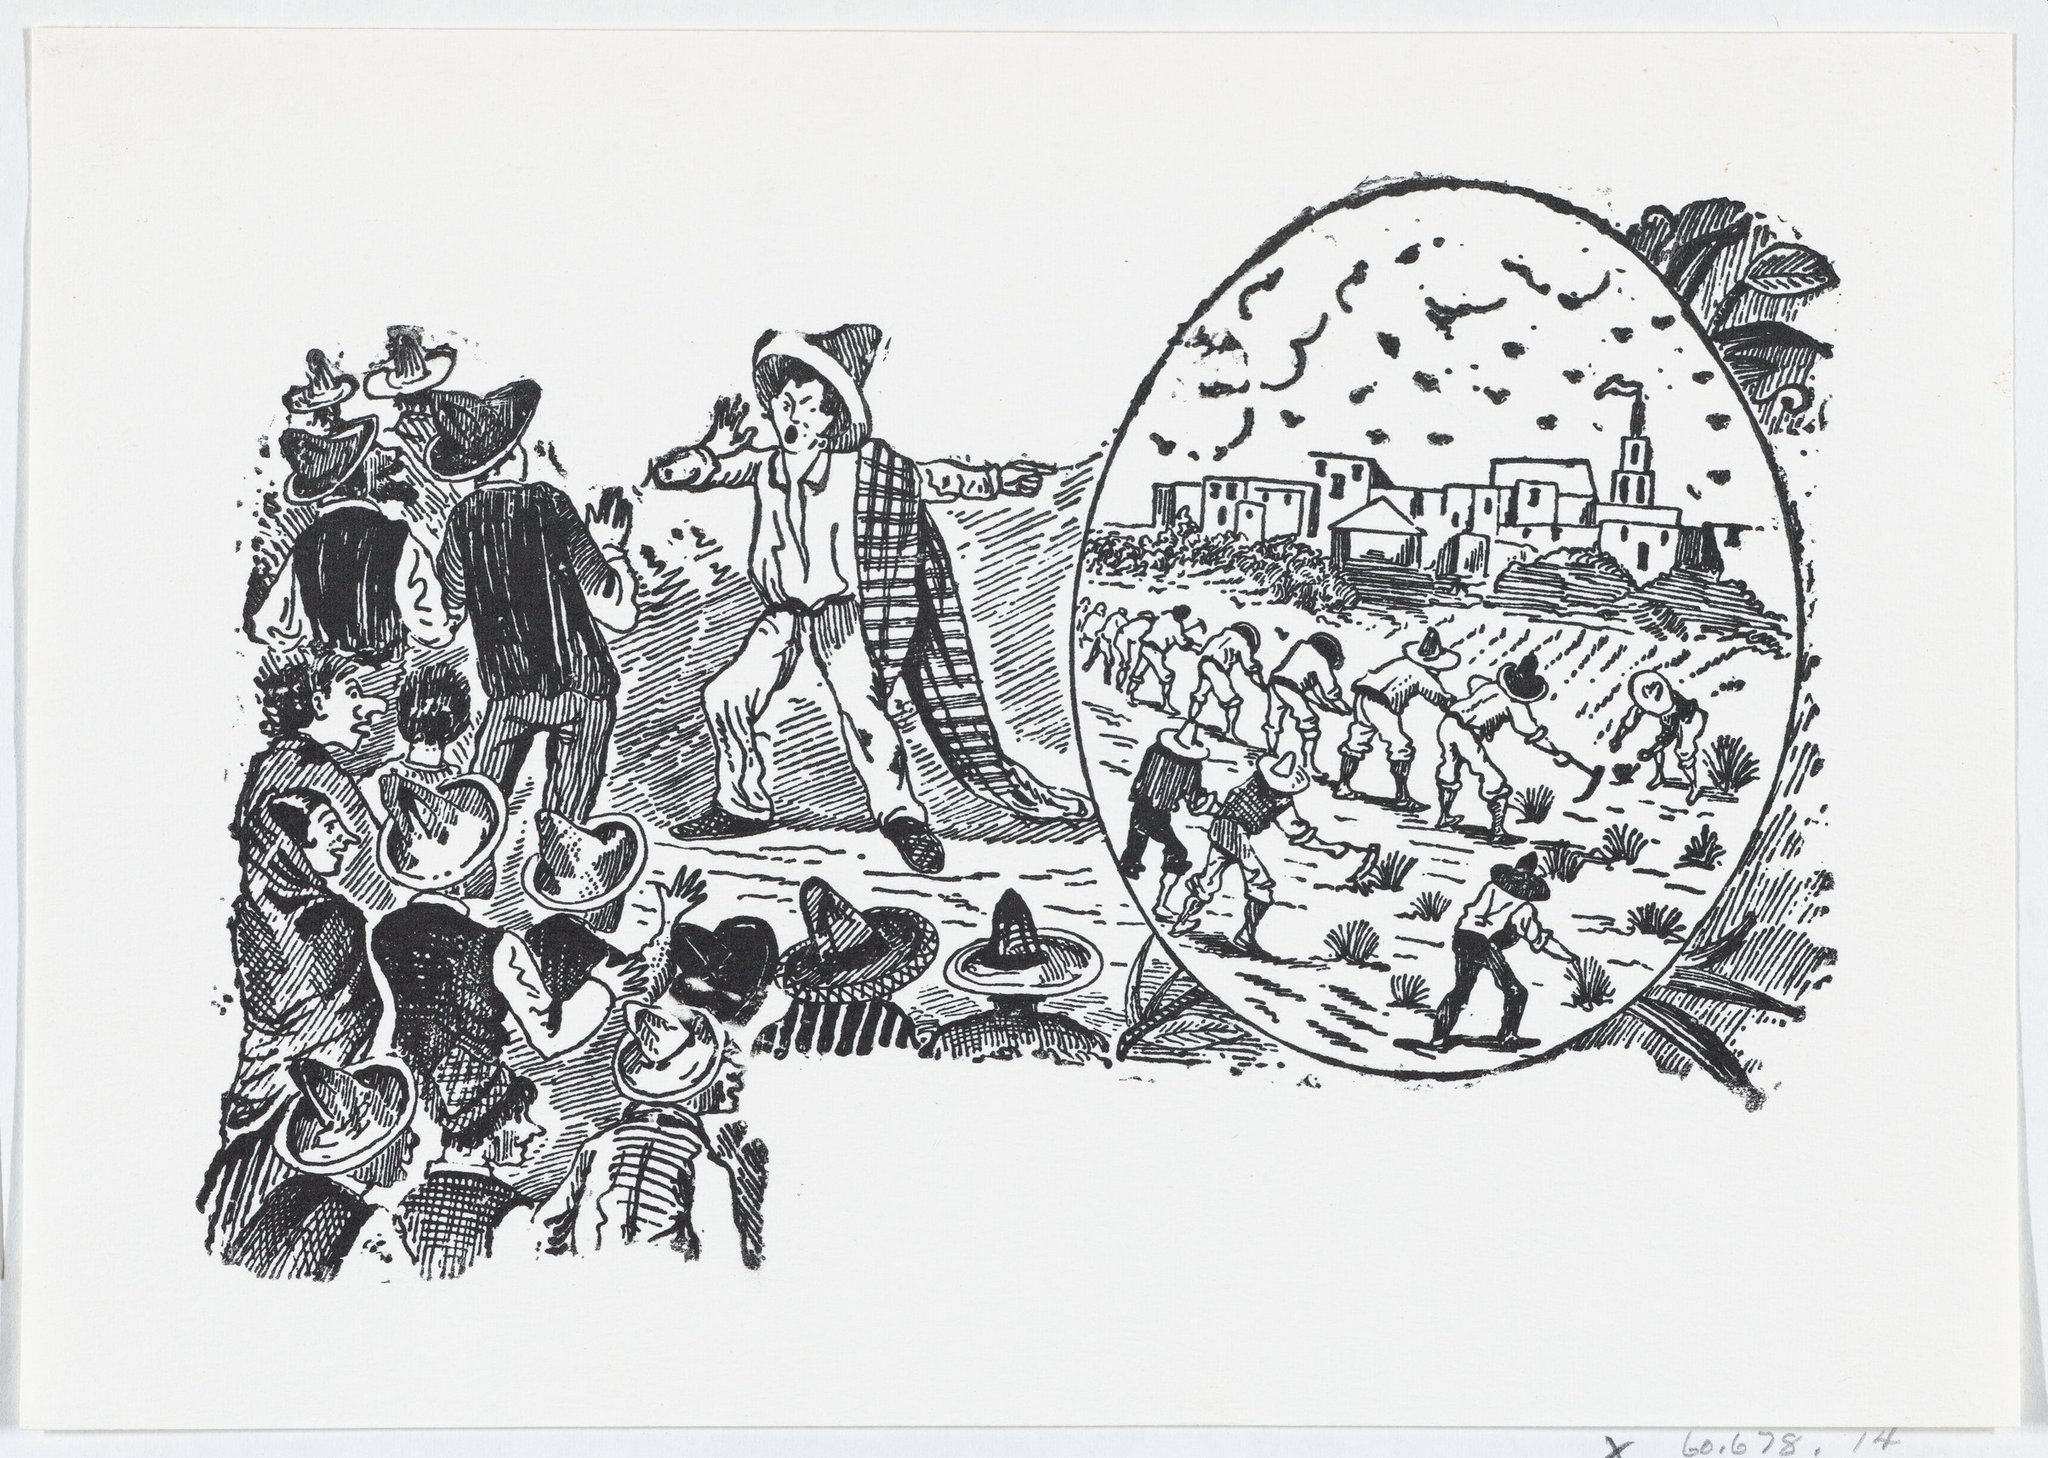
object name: print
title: A man warning townspeople about what could happen to them from a broadside entitled 'Deportados a las Islas Marias'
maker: josé guadalupe posada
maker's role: artist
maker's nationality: mexican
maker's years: 1852-1913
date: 1880-1910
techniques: lithography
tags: men,crowd,working